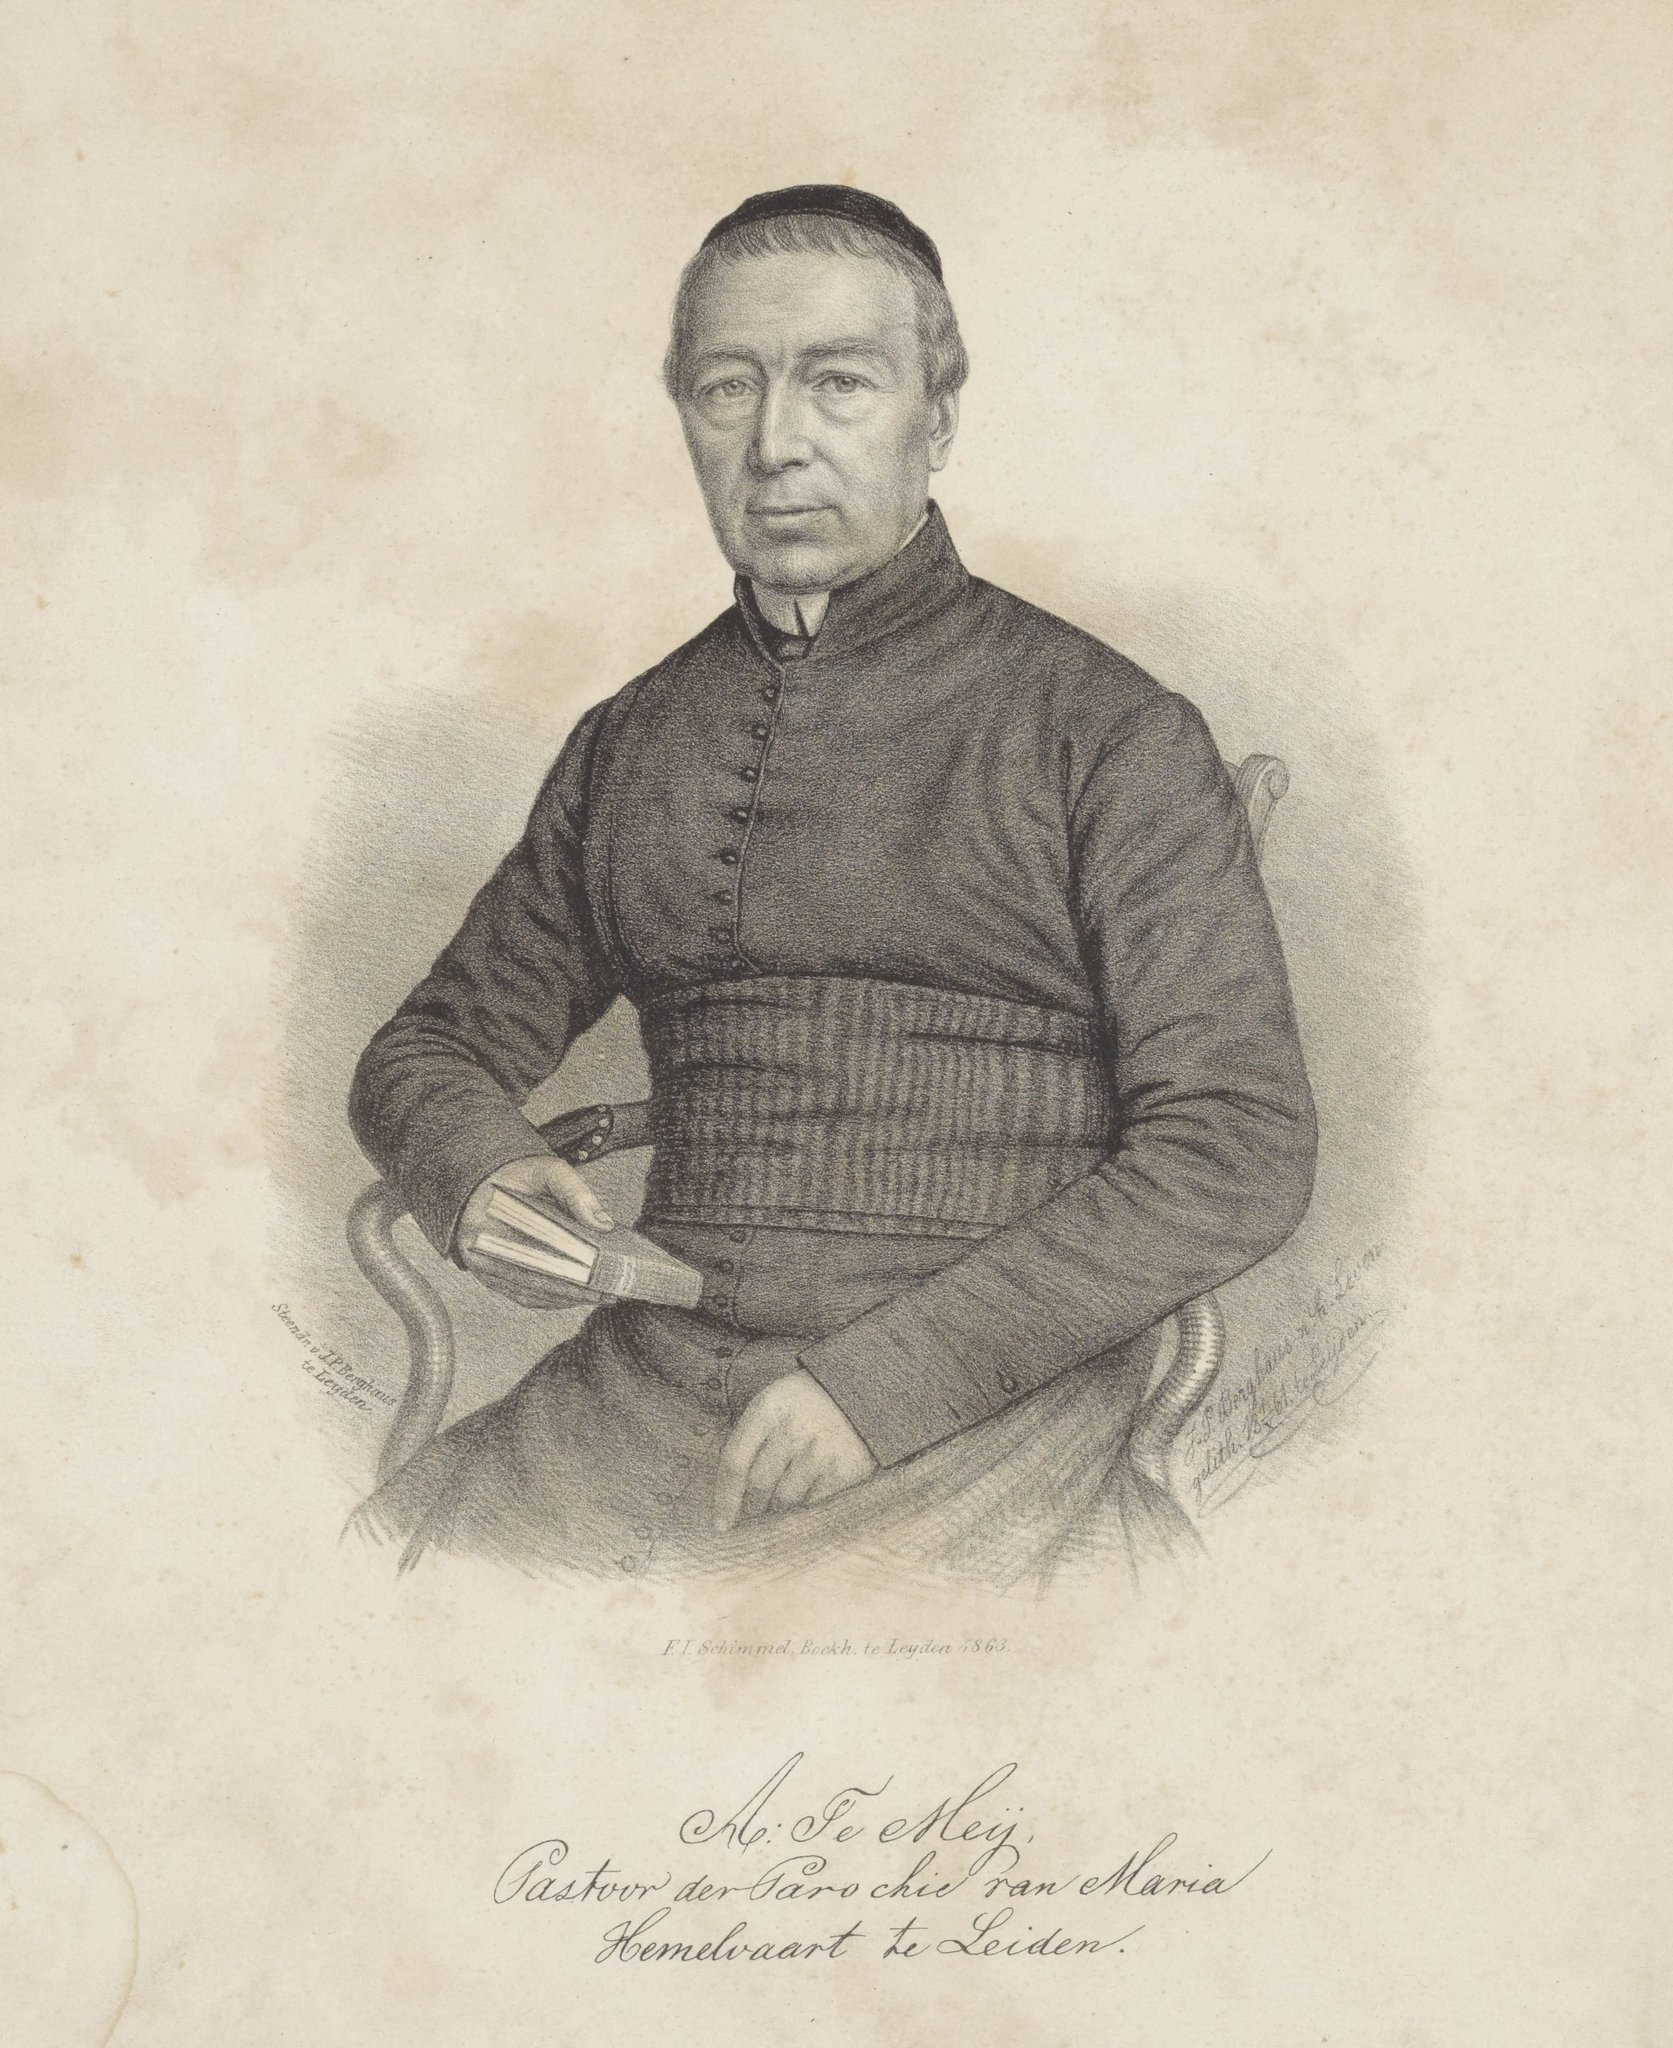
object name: print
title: Portret van pastoor A. te Mey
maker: johann peter berghaus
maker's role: print maker, printer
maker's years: 1810-1870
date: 1861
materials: paper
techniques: lithograph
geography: leiden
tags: historical persons, book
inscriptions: collector's mark: Lugt 2228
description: De geportretteerde zit op een houten stoel en draagt klerikale kleding. Hij heeft een boek in zijn rechterhand. Onder het portret zijn naam en de naam van zijn parochie.